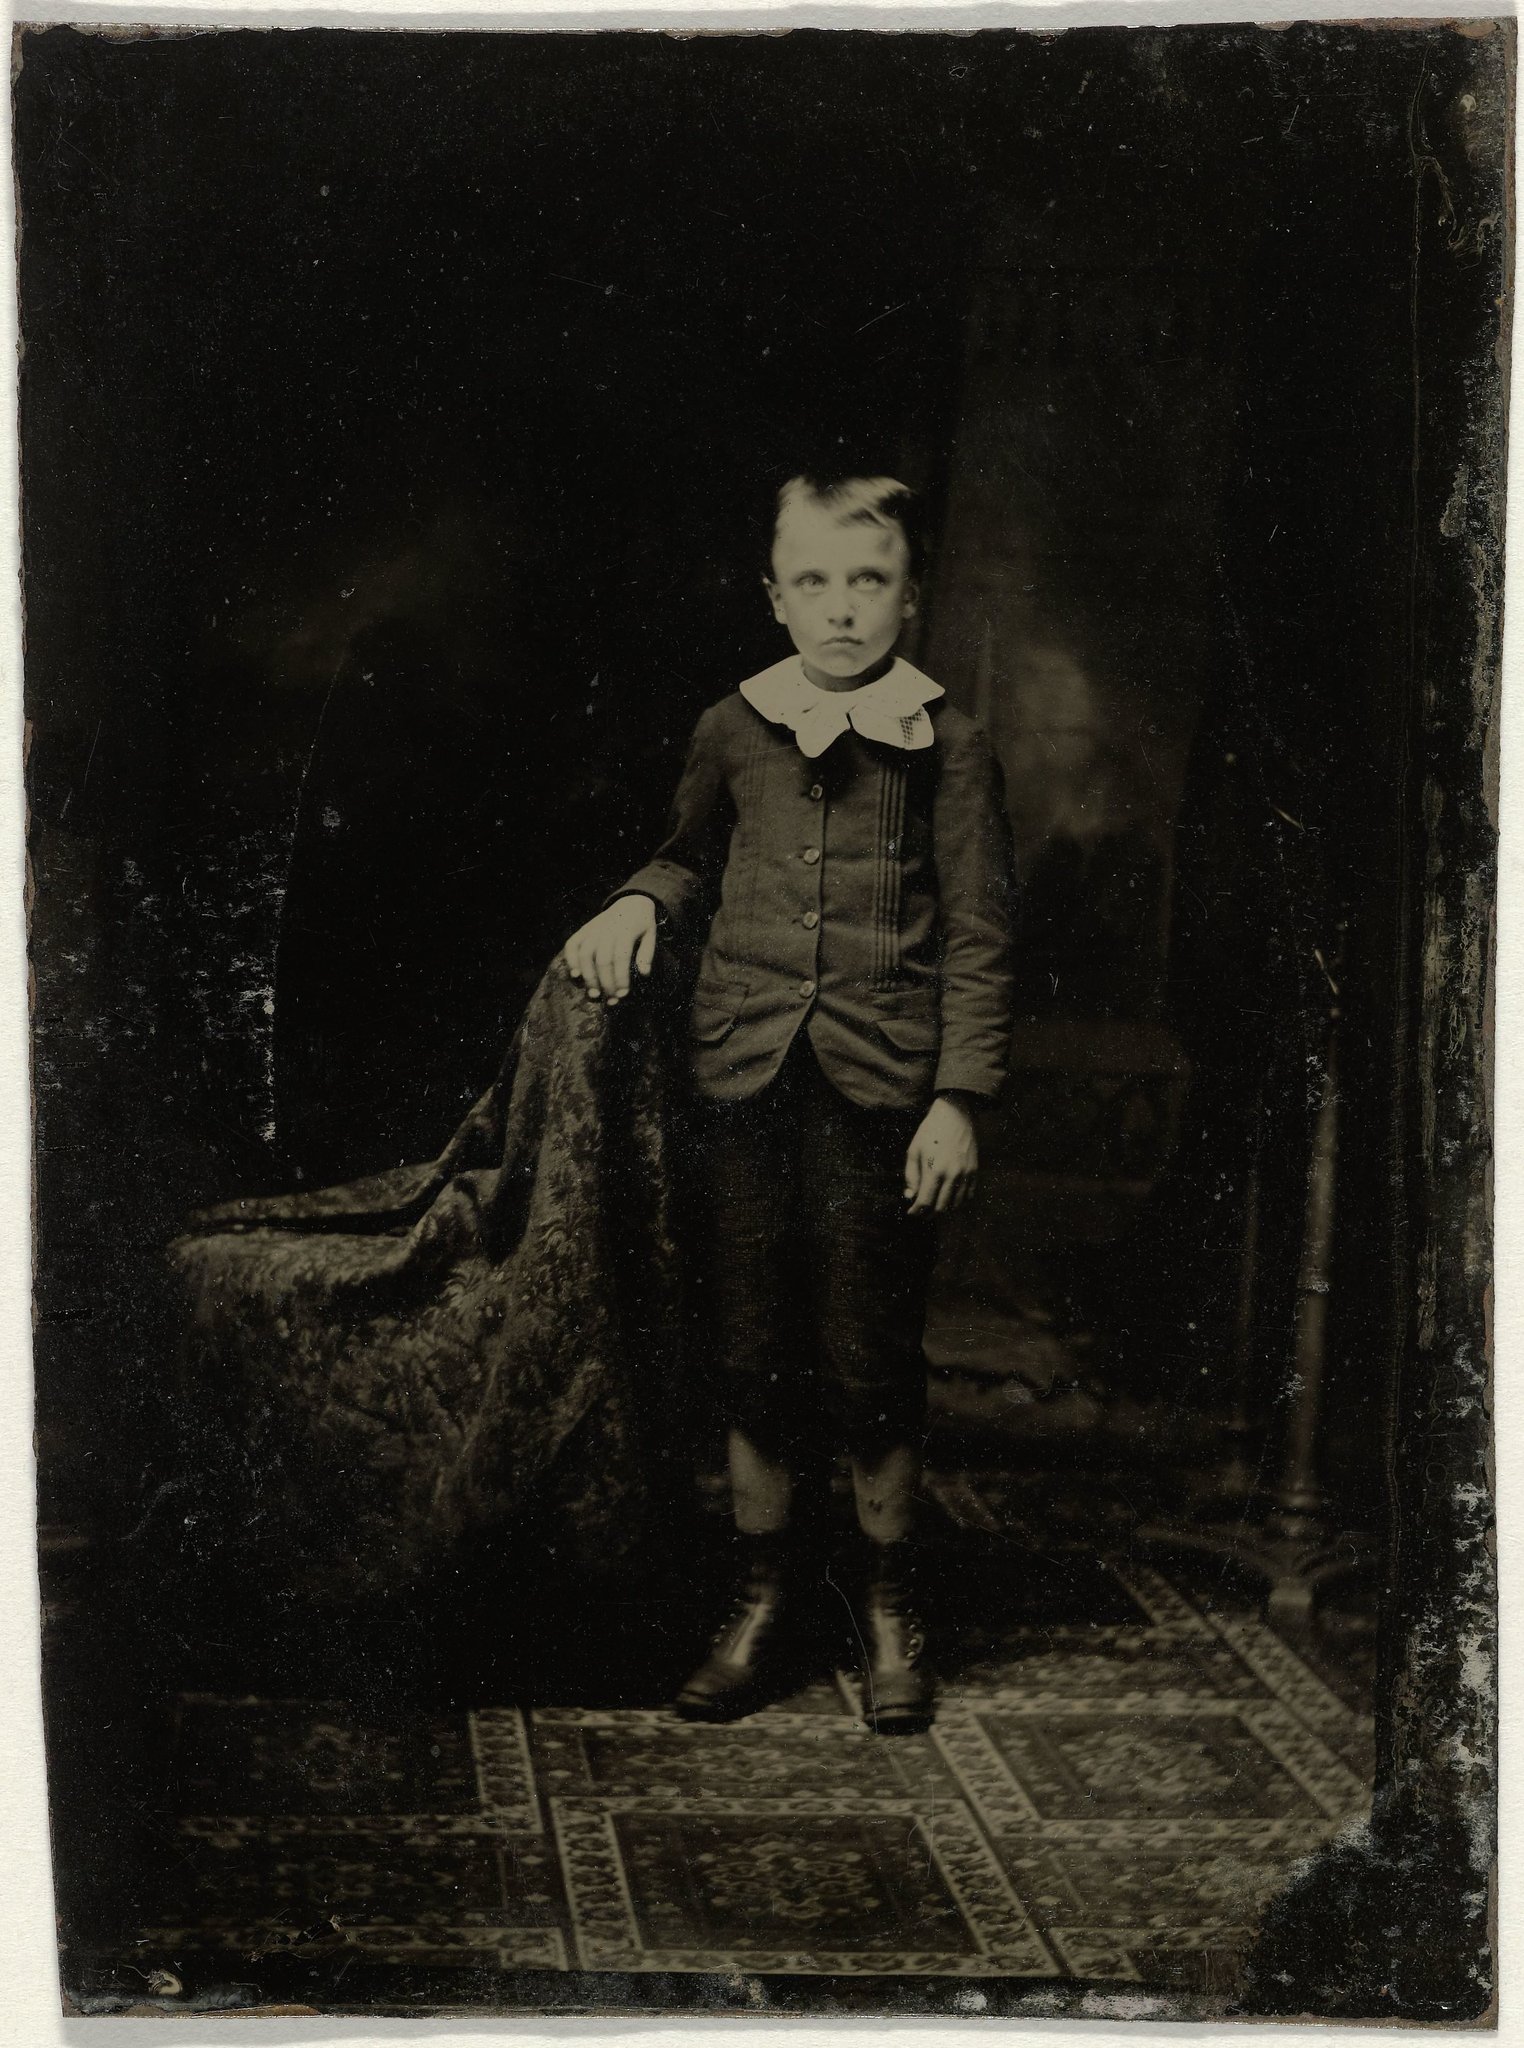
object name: photograph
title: Portret van een onbekende jongen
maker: Anonymous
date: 1860-1900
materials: metal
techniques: ferrotyping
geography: united states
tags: anonymous historical person portrayed